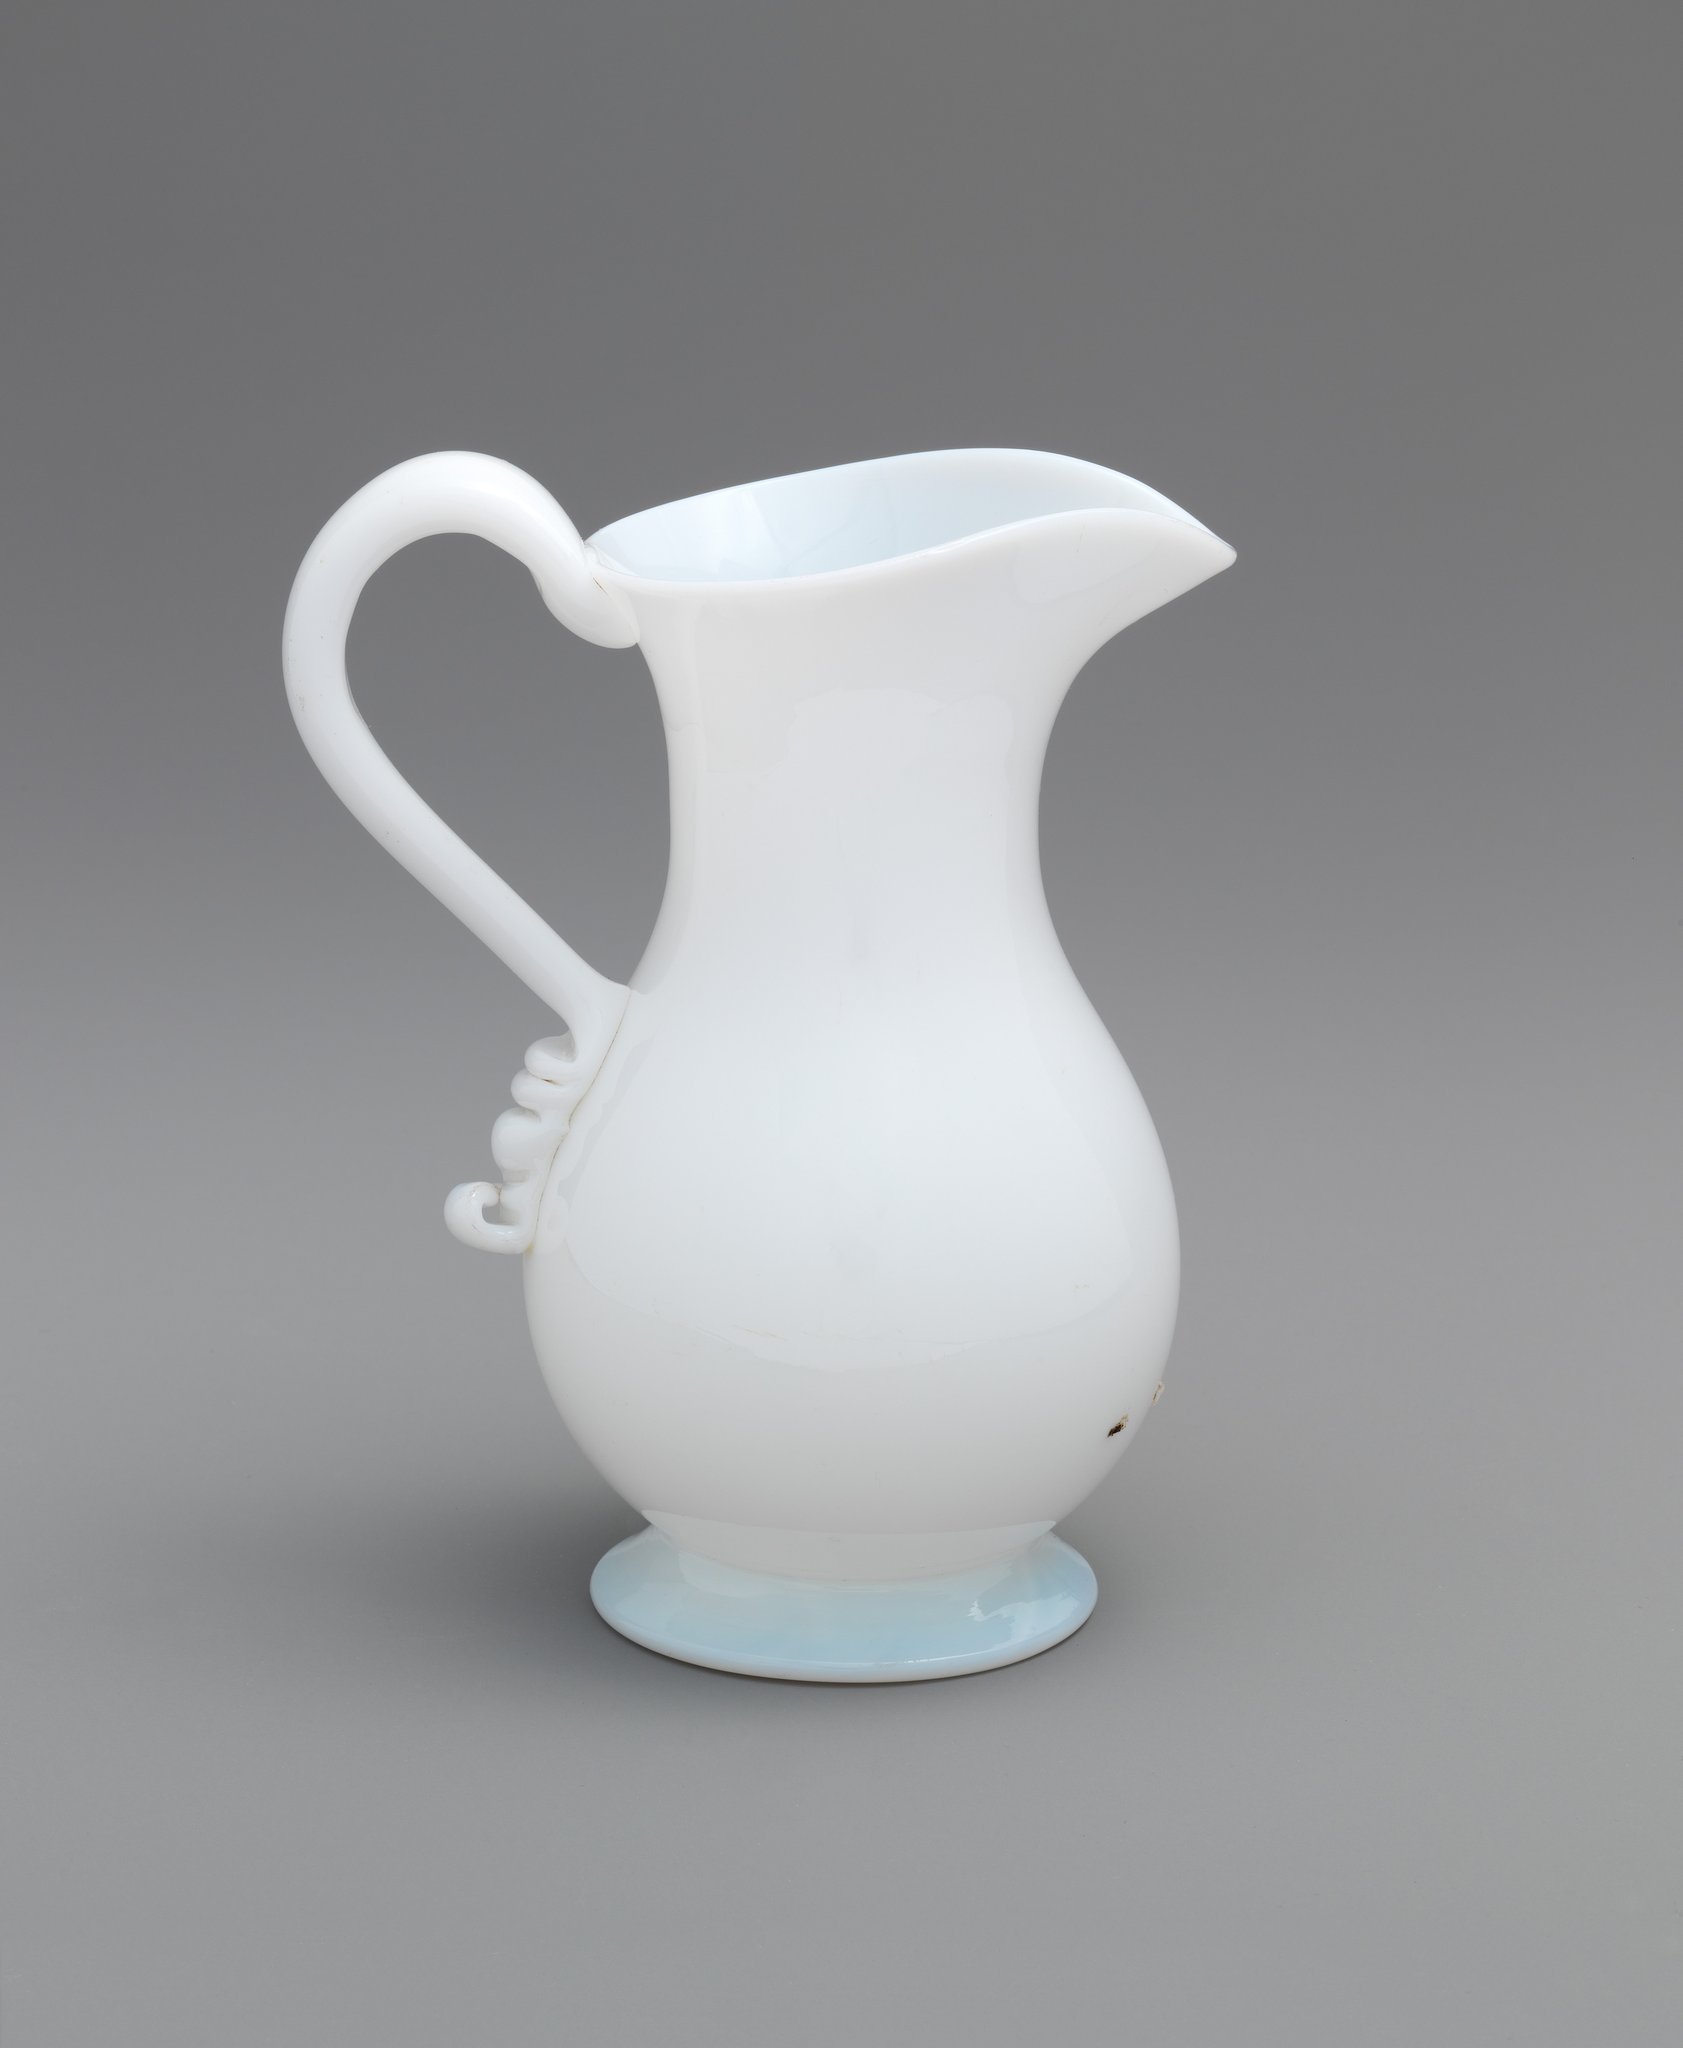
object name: pitcher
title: Cream pitcher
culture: american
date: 1830-1850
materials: glass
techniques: glassblowing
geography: united states